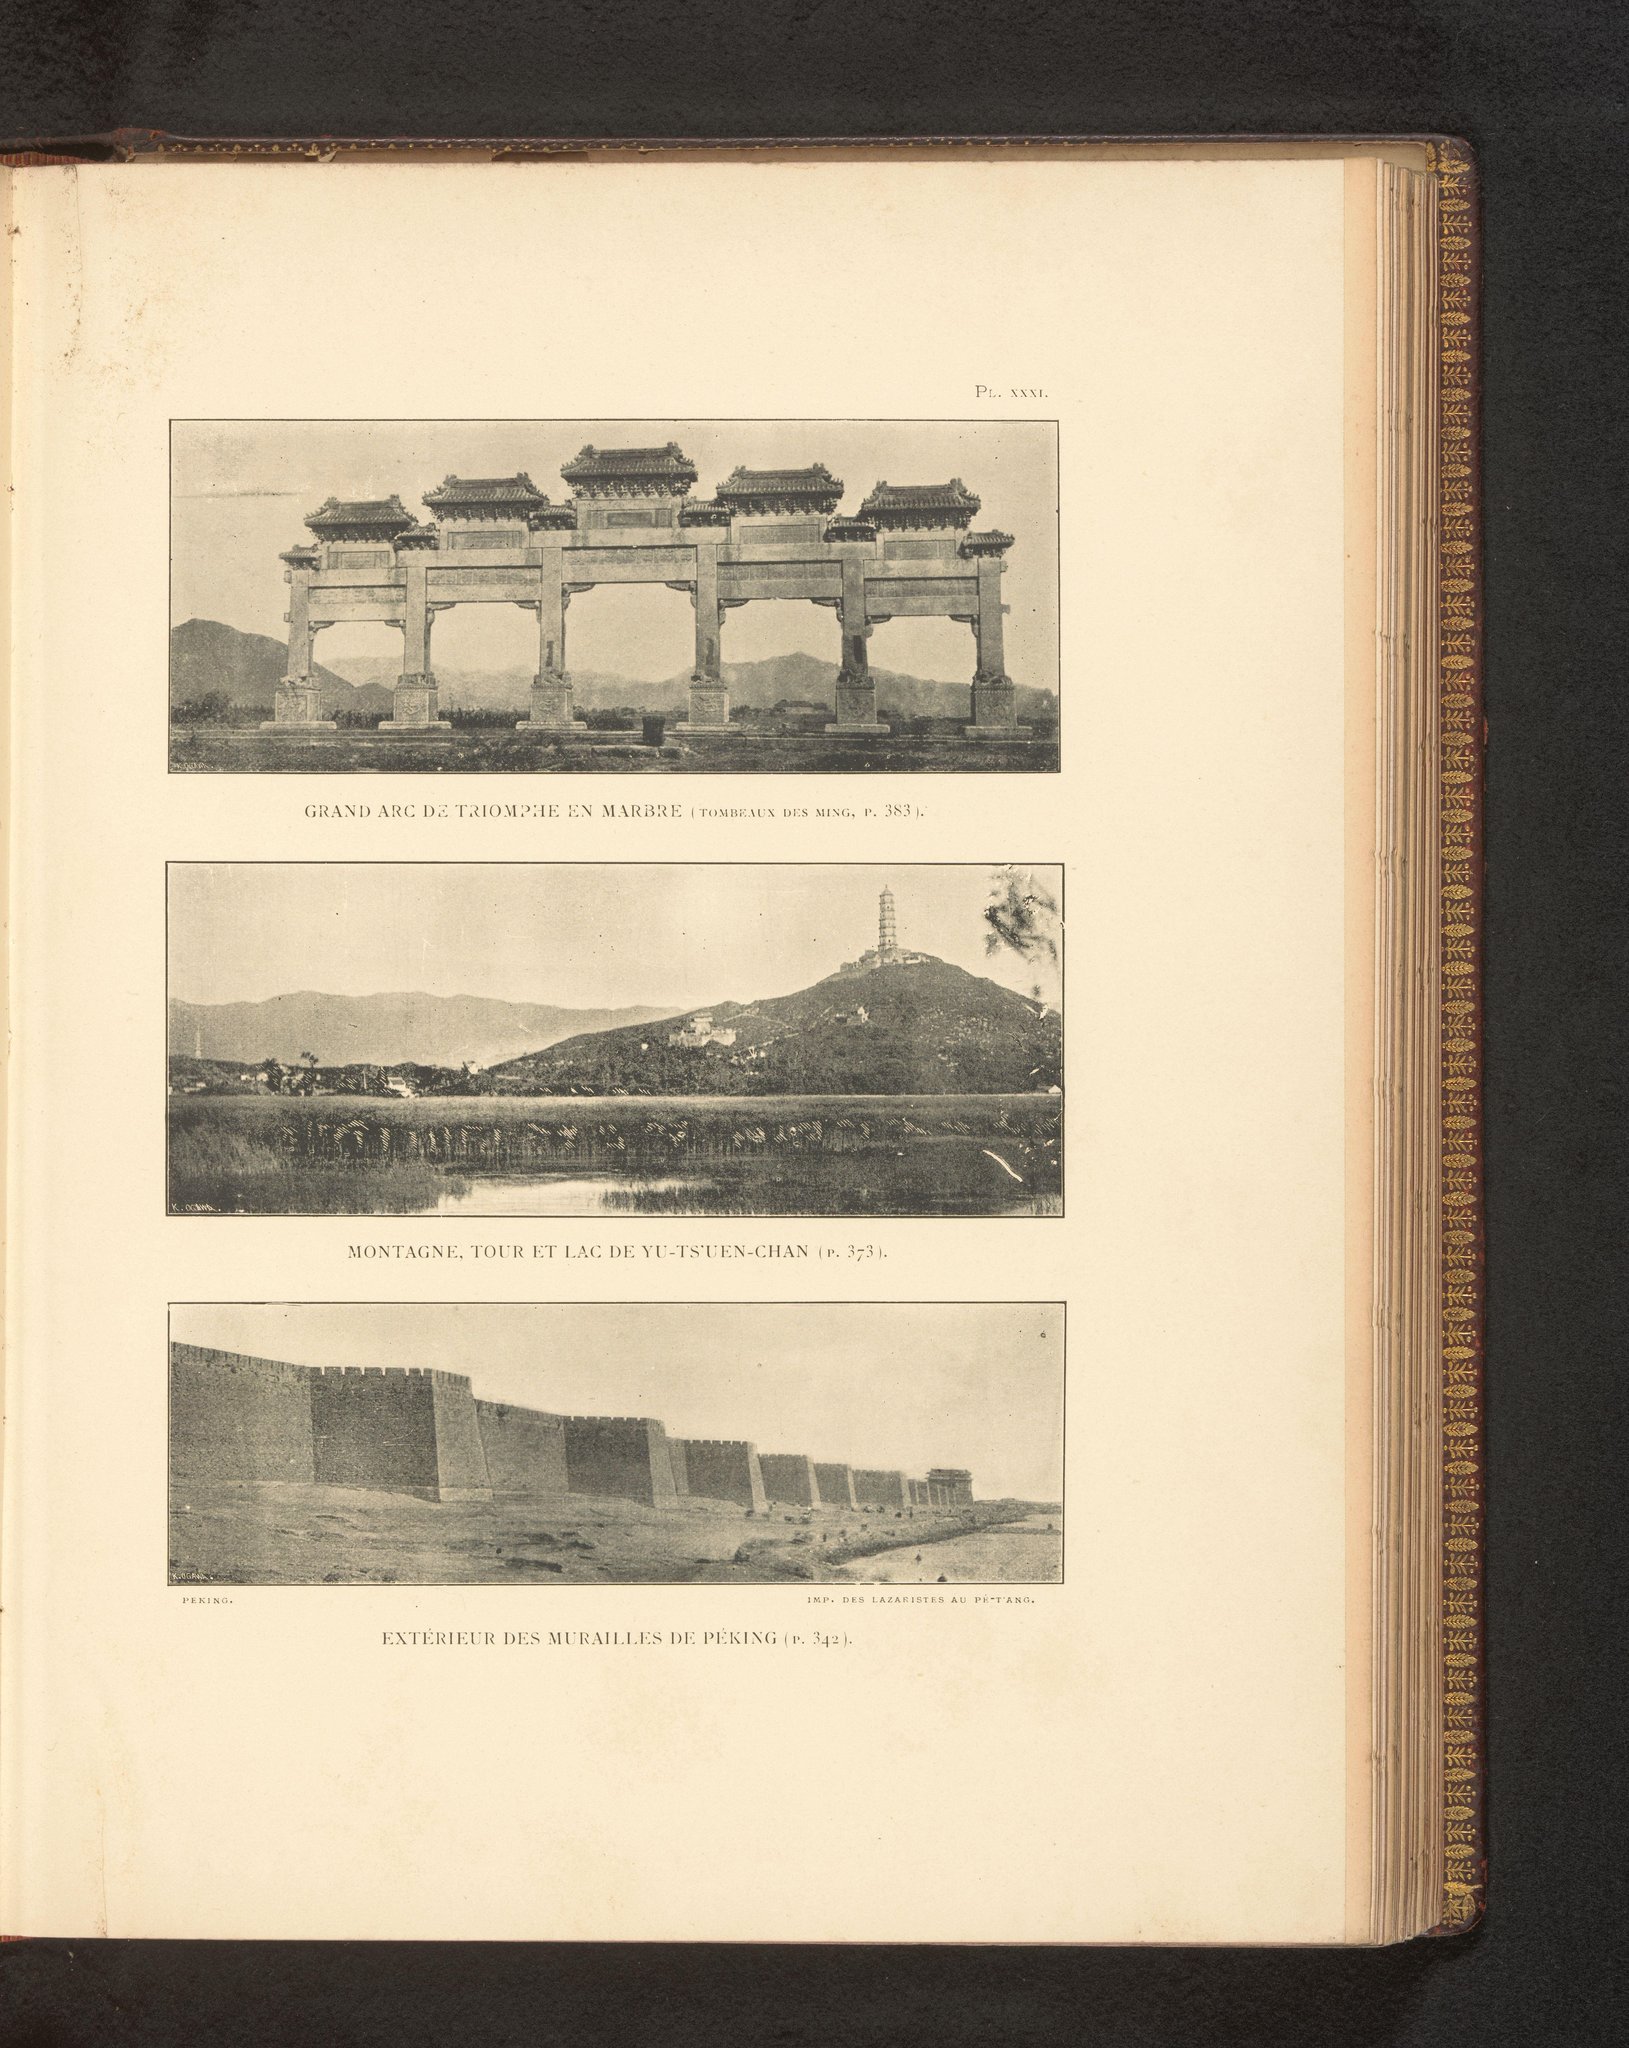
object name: page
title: Gezicht op de triomfboog bij de Ming-tombes, Gezicht op een toren op een berg bij een water en Gezicht op de stadsmuur van Peking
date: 1892-1897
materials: paper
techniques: autotype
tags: triumphal arch, city-walls, mountains